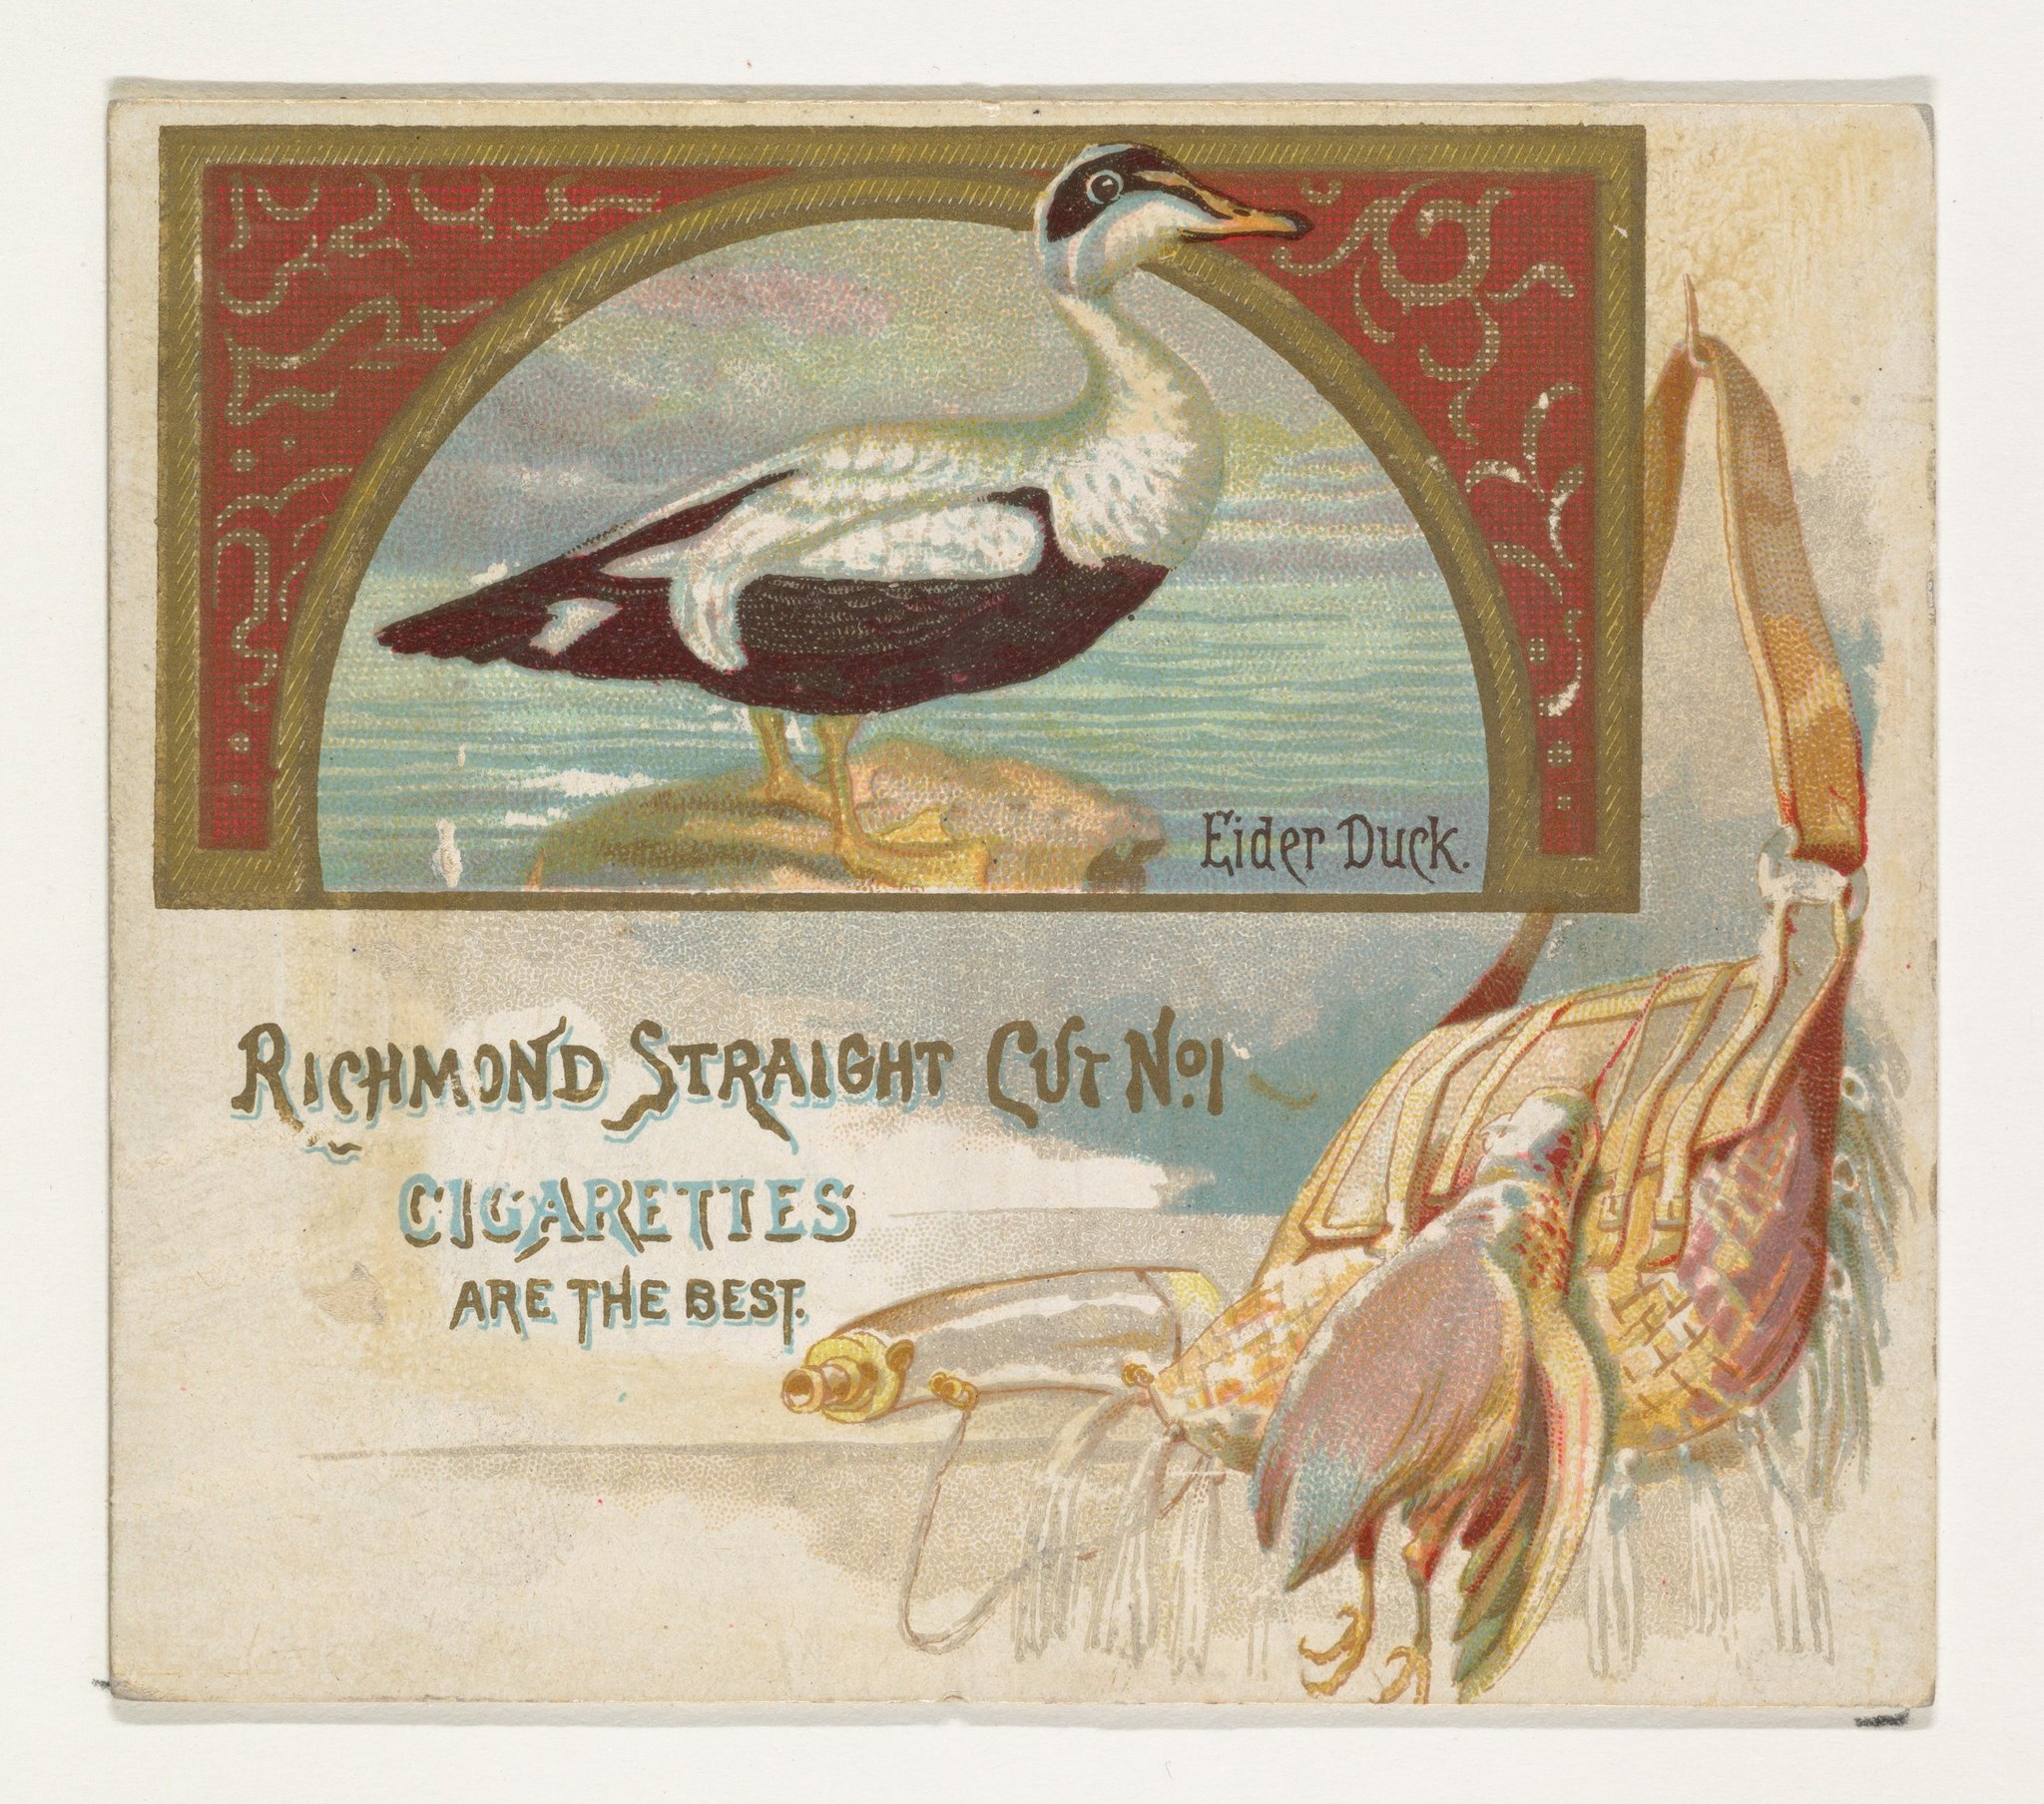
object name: print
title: Eider Duck, from the Game Birds series (N40) for Allen & Ginter Cigarettes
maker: allen & ginter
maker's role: publisher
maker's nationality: american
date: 1888-1890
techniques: color lithograph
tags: ducks